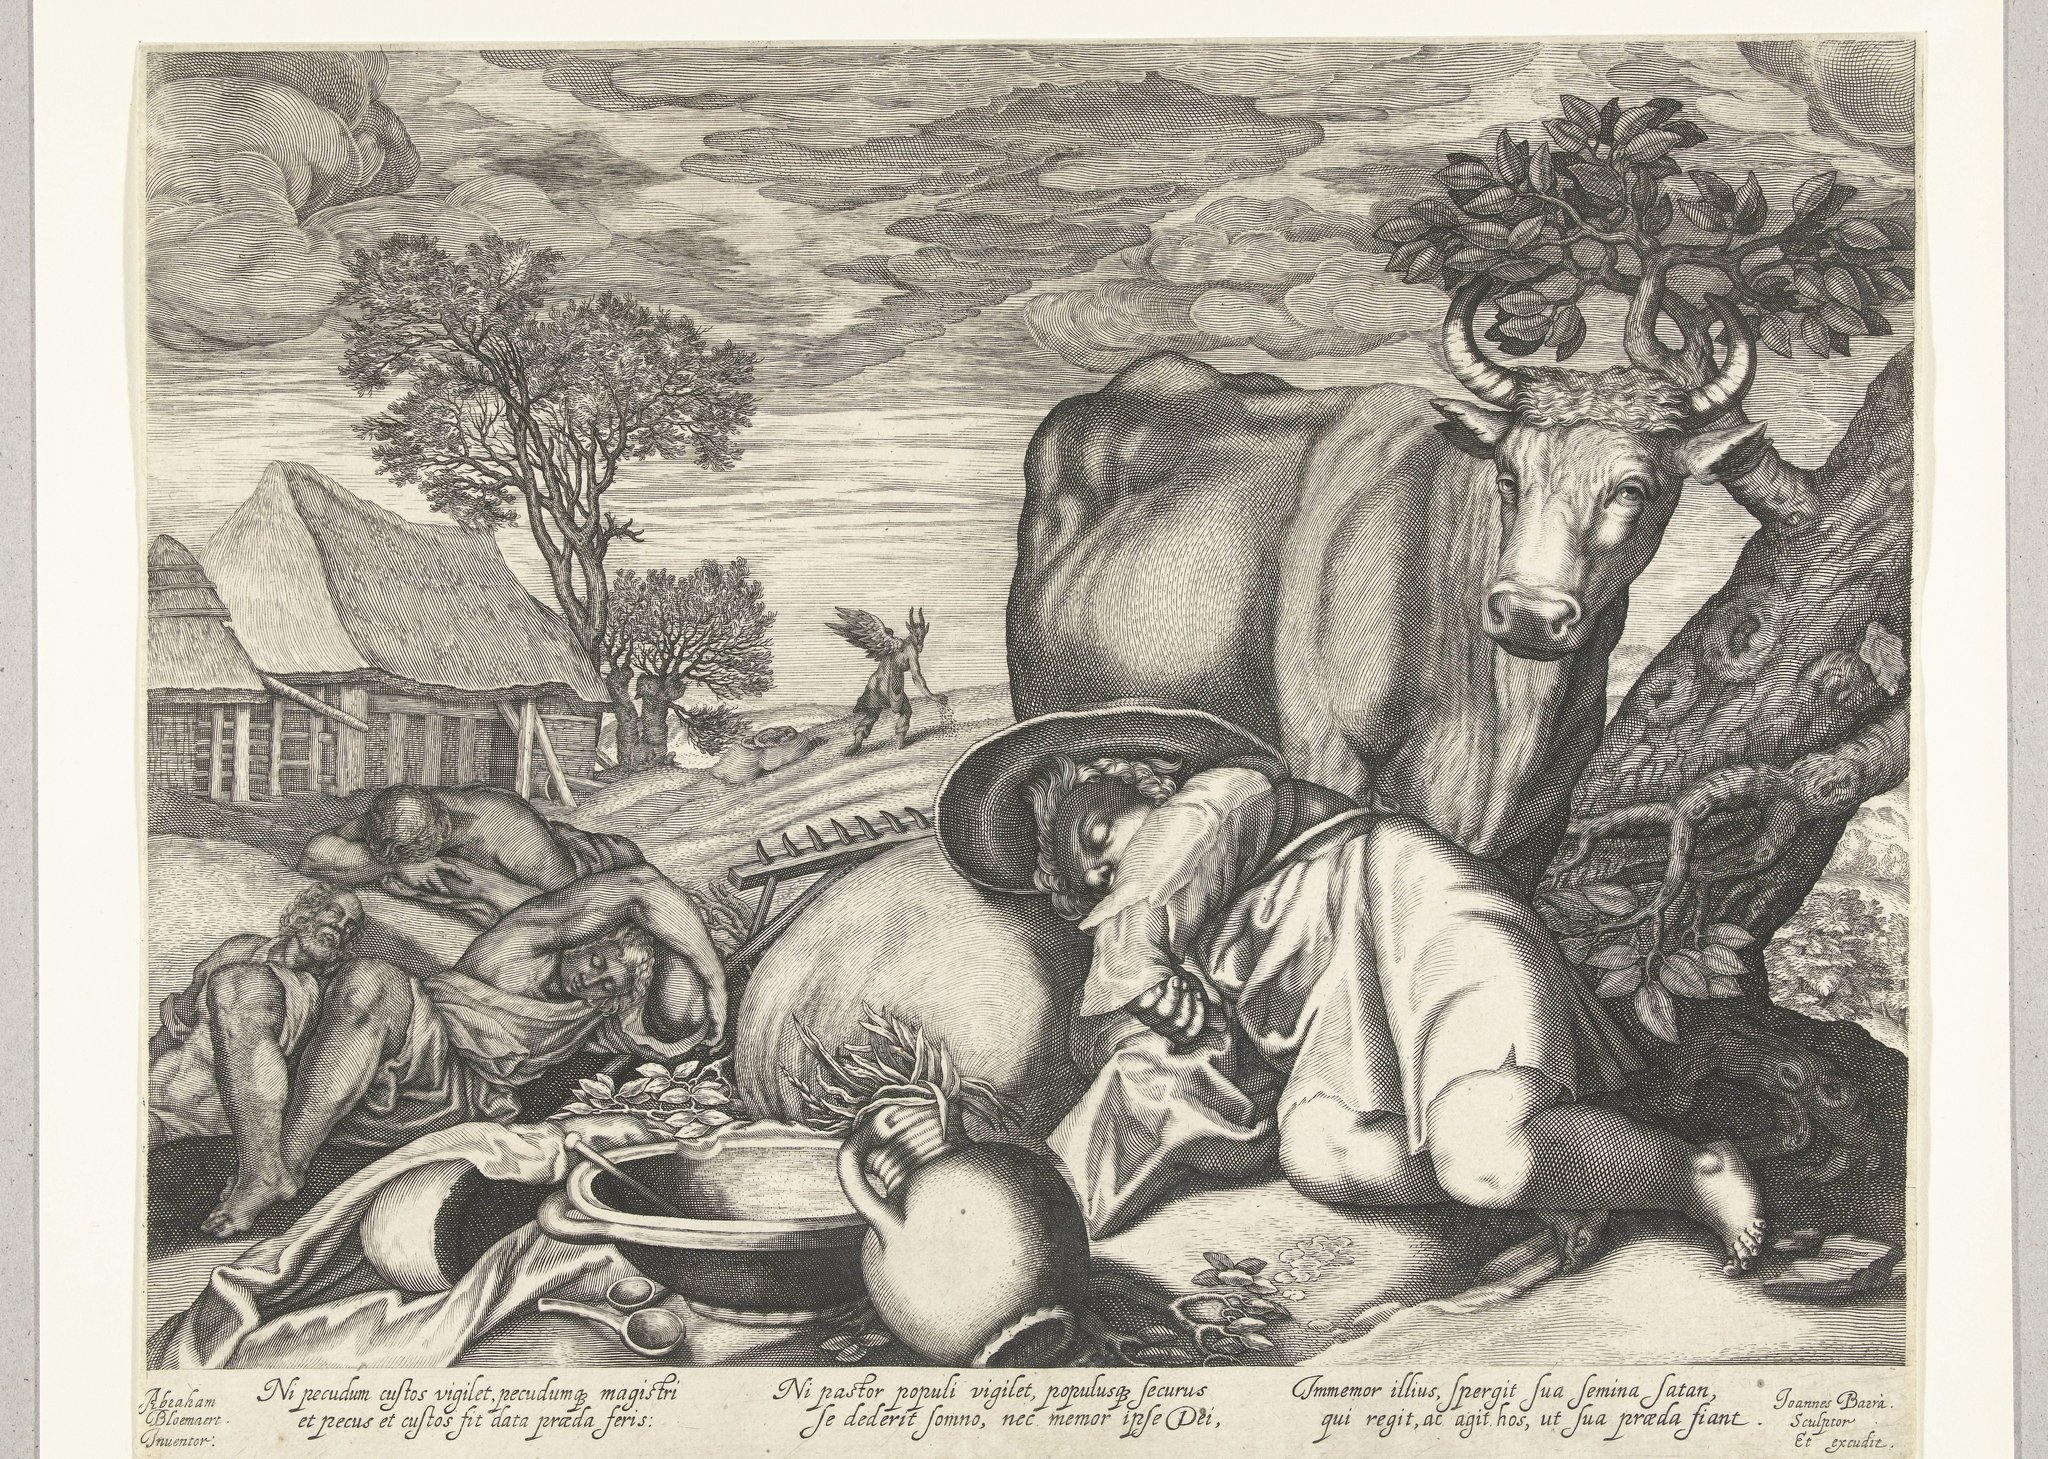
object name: print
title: Zaaier en knechten slapen terwijl Satan onkruid zaait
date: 1591-1634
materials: paper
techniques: engraving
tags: sleeping on the ground - bb - out of doors, while the sower and his servants slept, his enemy (the devil) sowed tares among the wheat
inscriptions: collector's mark: Lugt 240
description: Een zaaier of boer ligt samen met zijn knechten te slapen na hun werk in het veld. Terwijl zij rusten zaait Satan onkruid tussen het koren. Onder de voorstelling staat een Latijns citaat van de bijbeltekst Mattheus 13:24-30.